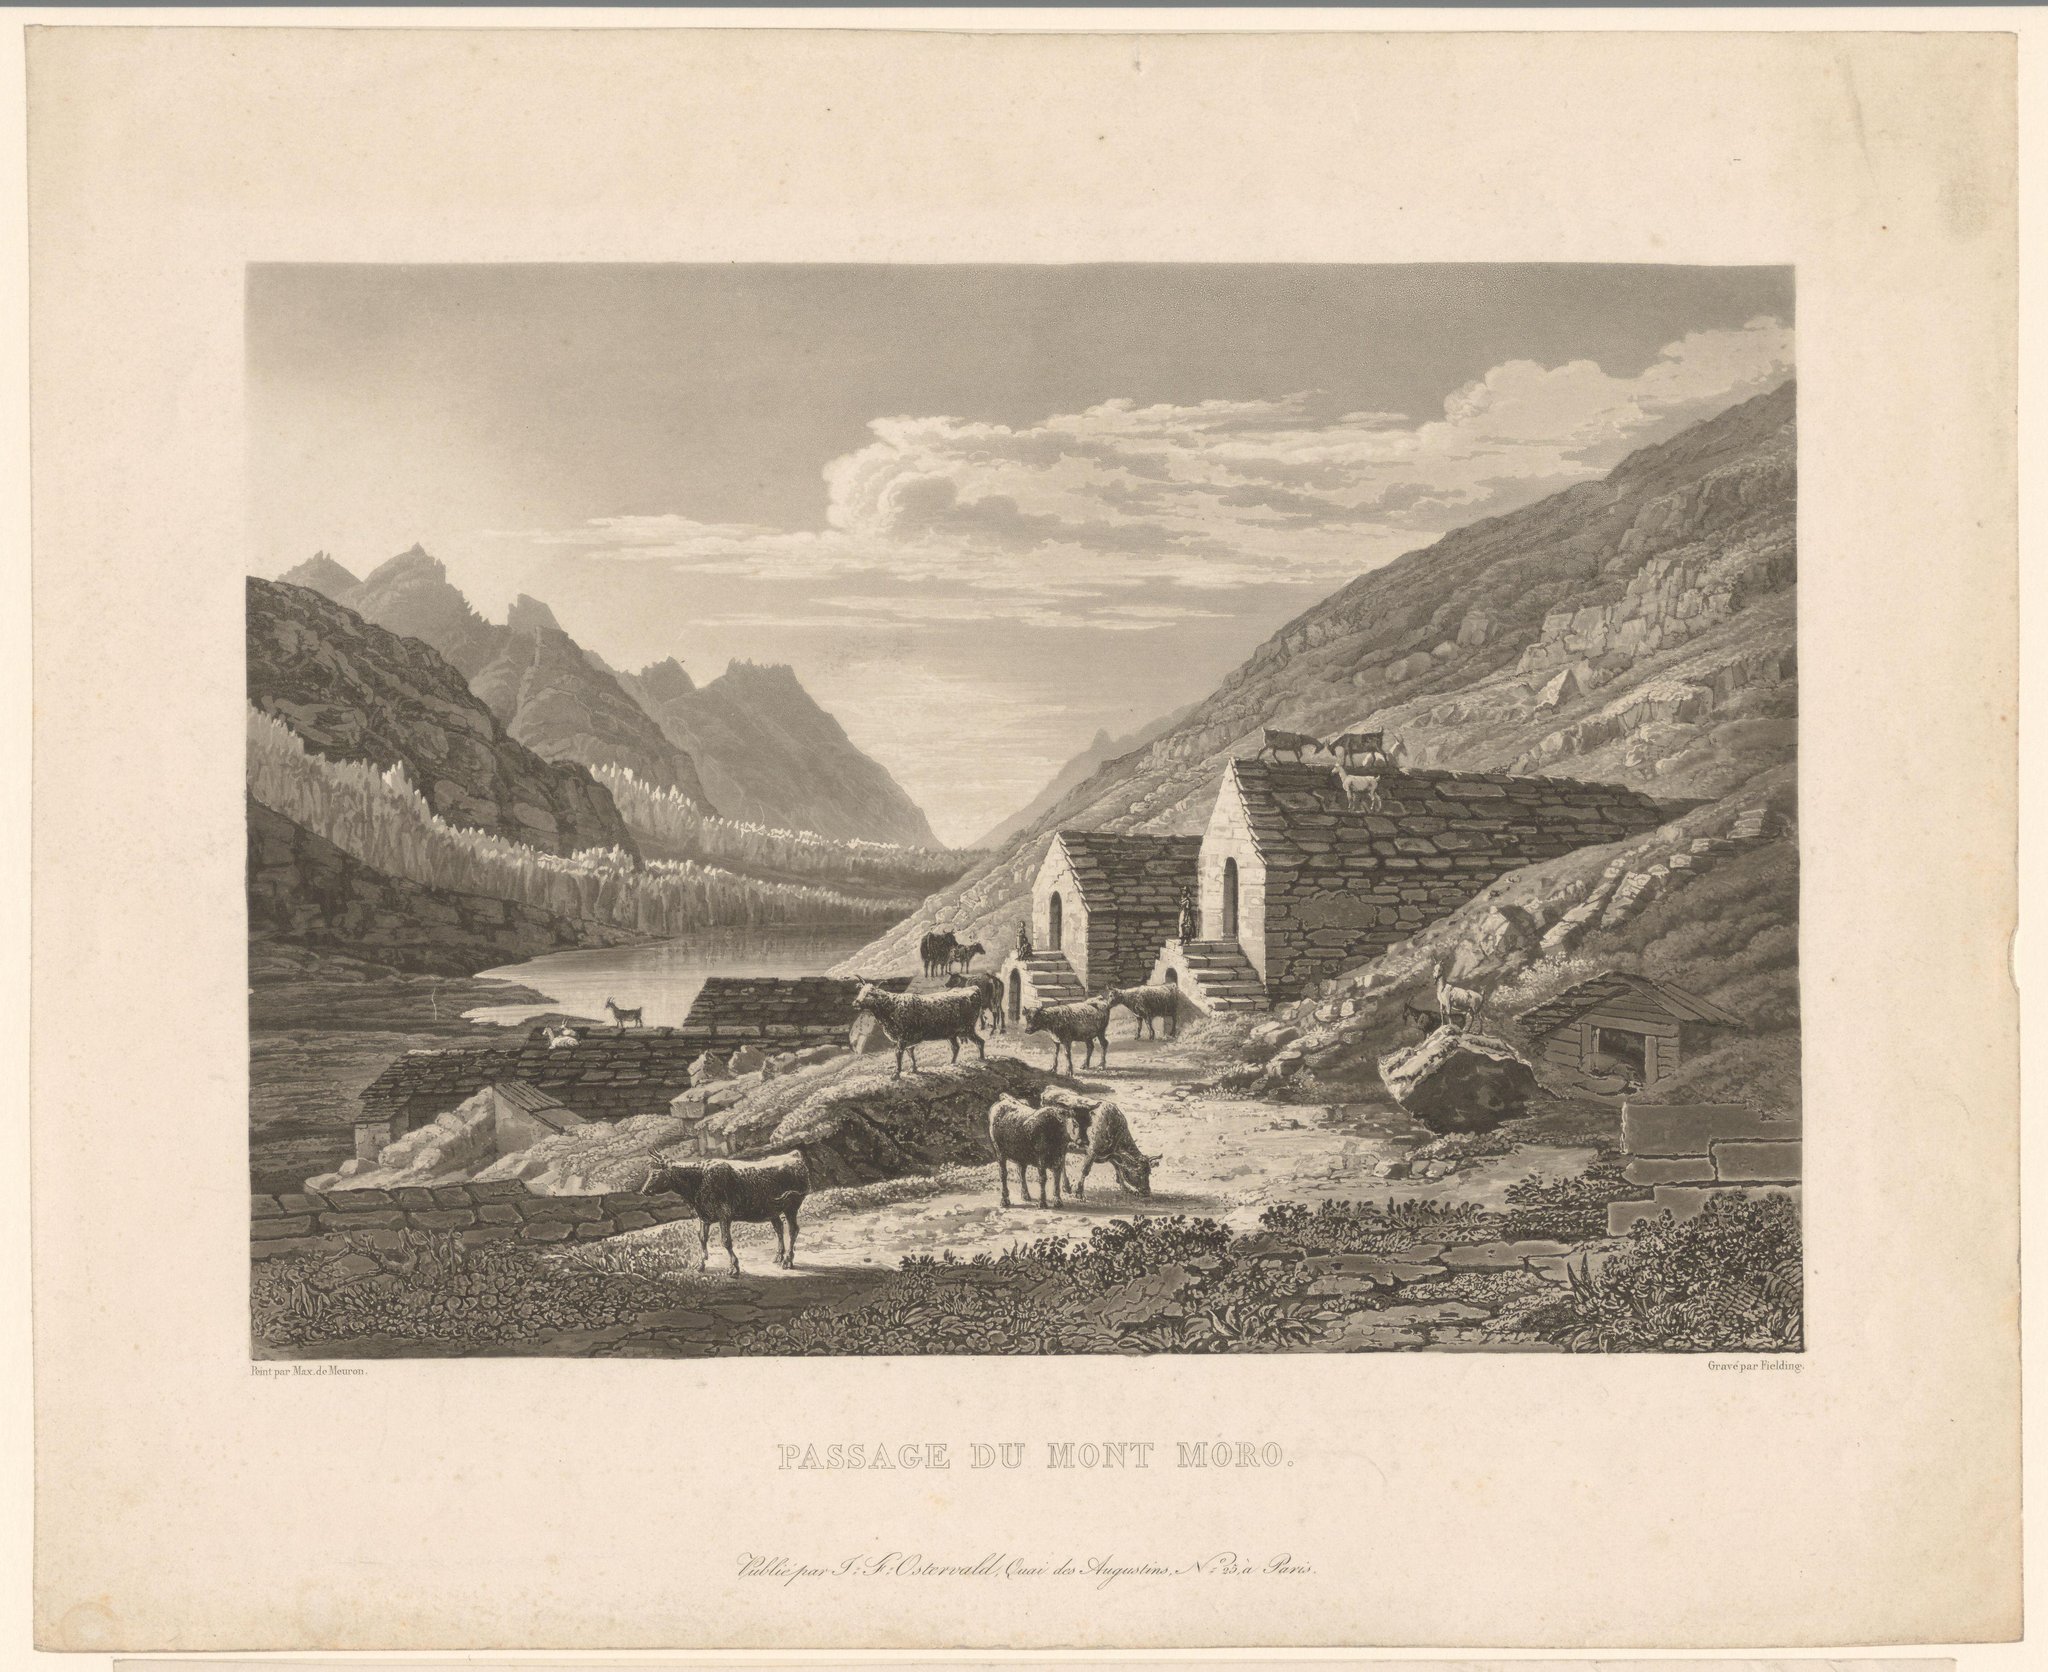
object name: print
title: Gezicht op de Monte Moropas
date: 1821-1837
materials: paper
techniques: aquatint, etching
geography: paris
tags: cow, lake, mountains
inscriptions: collector's mark: Lugt 2228